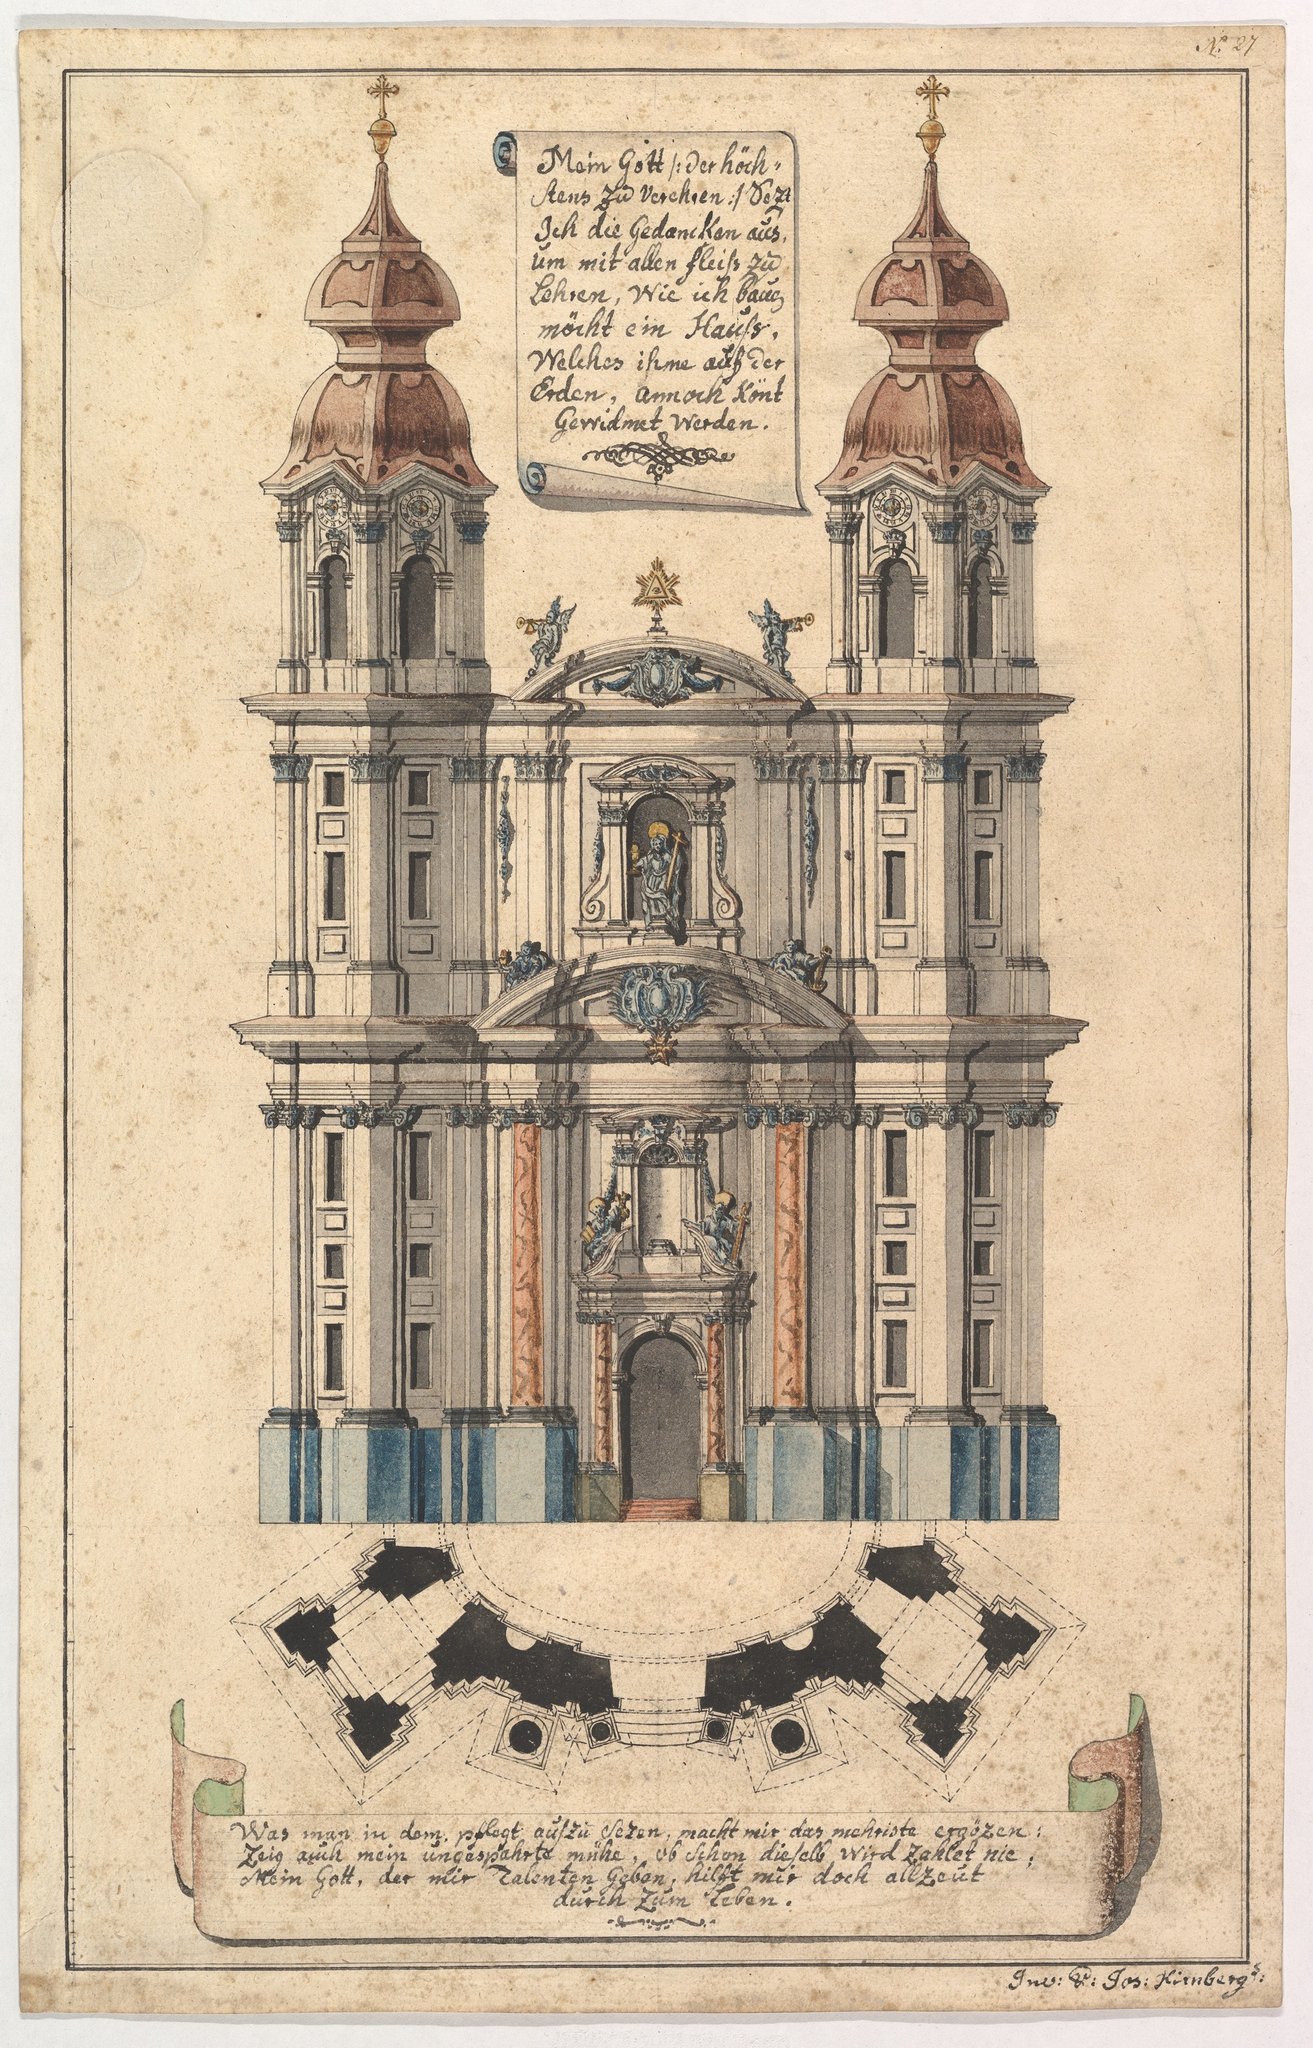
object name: drawing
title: Baroque Church Façade with Obliquely Placed Towers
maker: joseph kirnberger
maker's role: artist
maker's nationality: german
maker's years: 1735-1795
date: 1760-1770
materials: graphite, ink, watercolor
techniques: pen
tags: architecture,churches